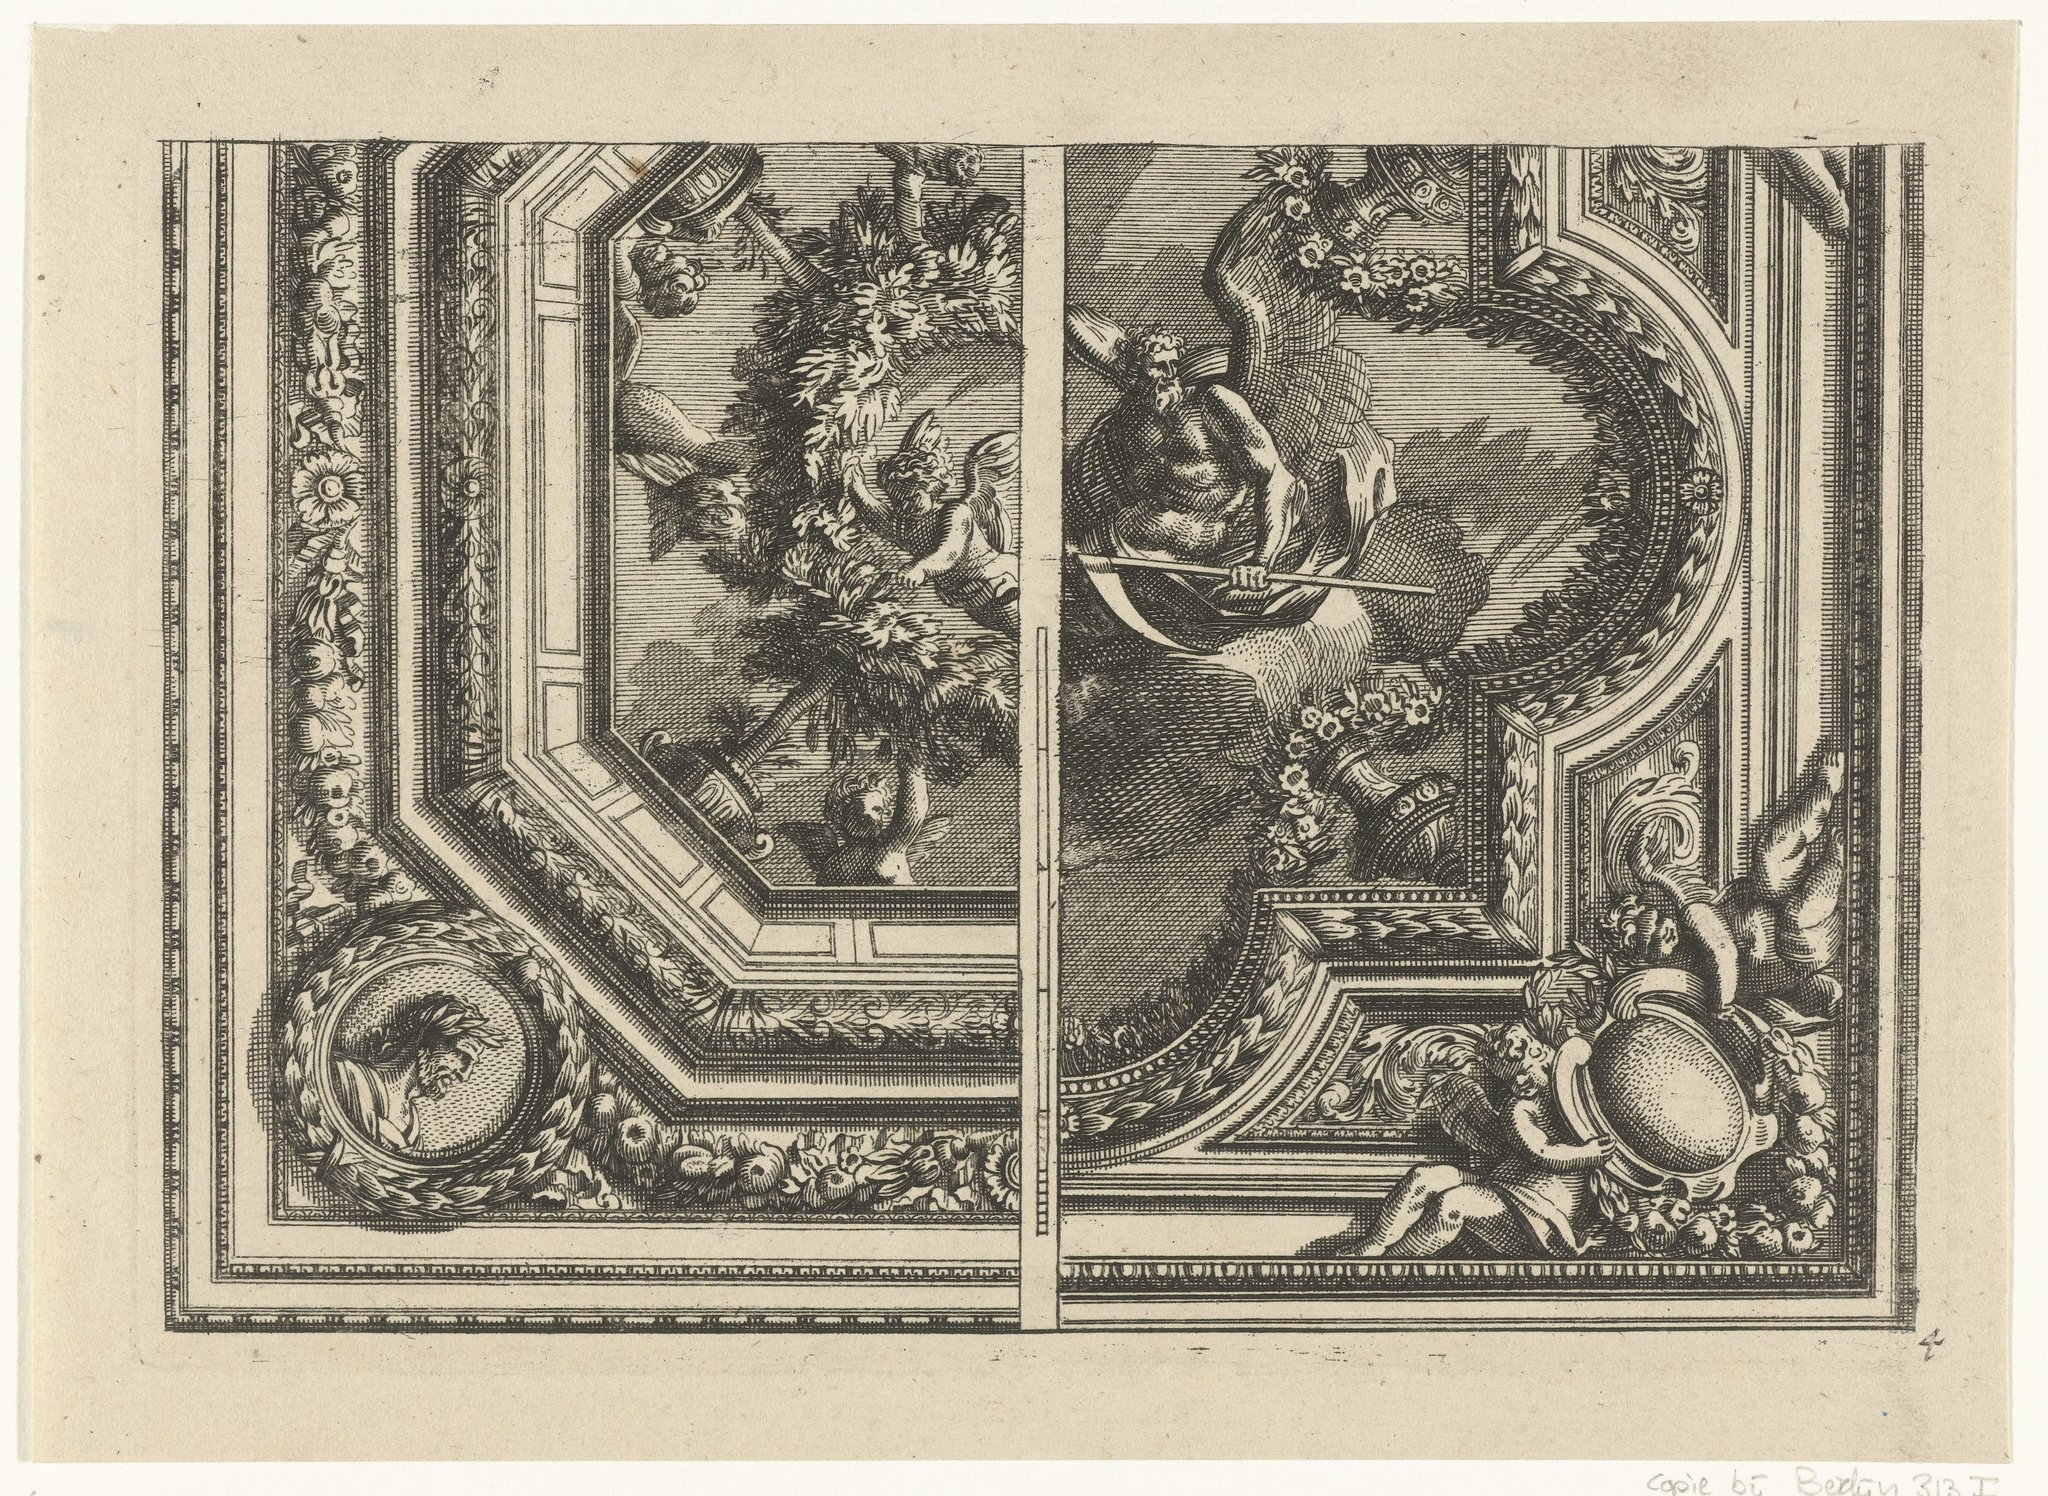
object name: ornament print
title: Twee kwarten van plafonds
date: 1668-1716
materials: paper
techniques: etching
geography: nuremberg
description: De hoek van het plafond links is gedecoreerd met een medaillon met een keizersbuste.